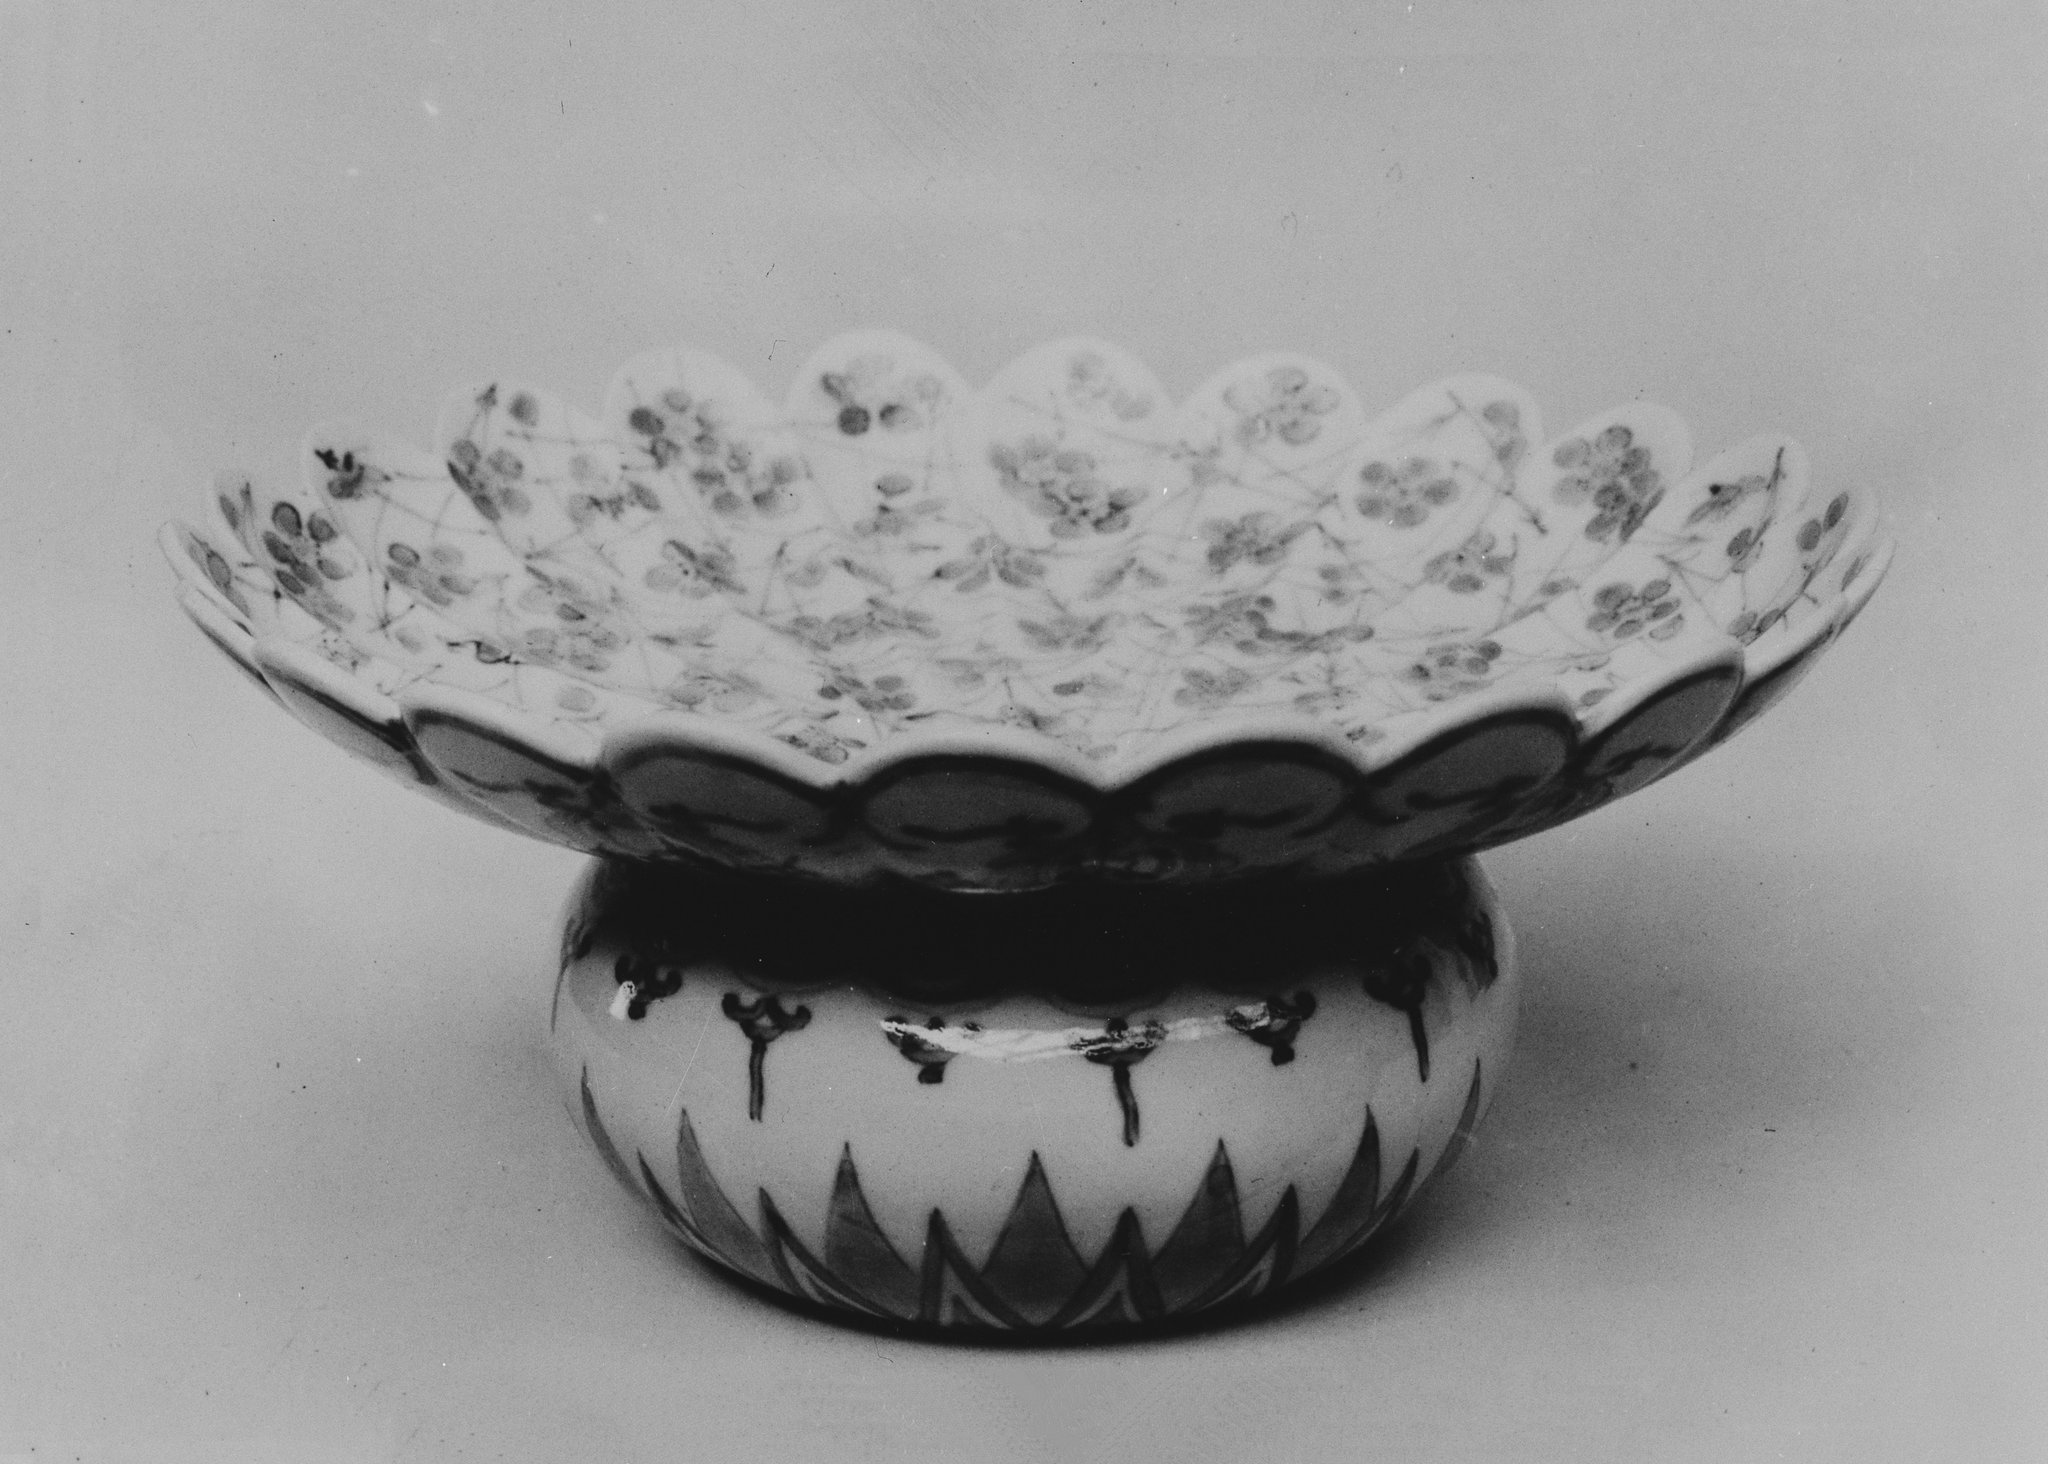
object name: dish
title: Melon Dish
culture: japanese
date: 1760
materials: glaze, porcelain